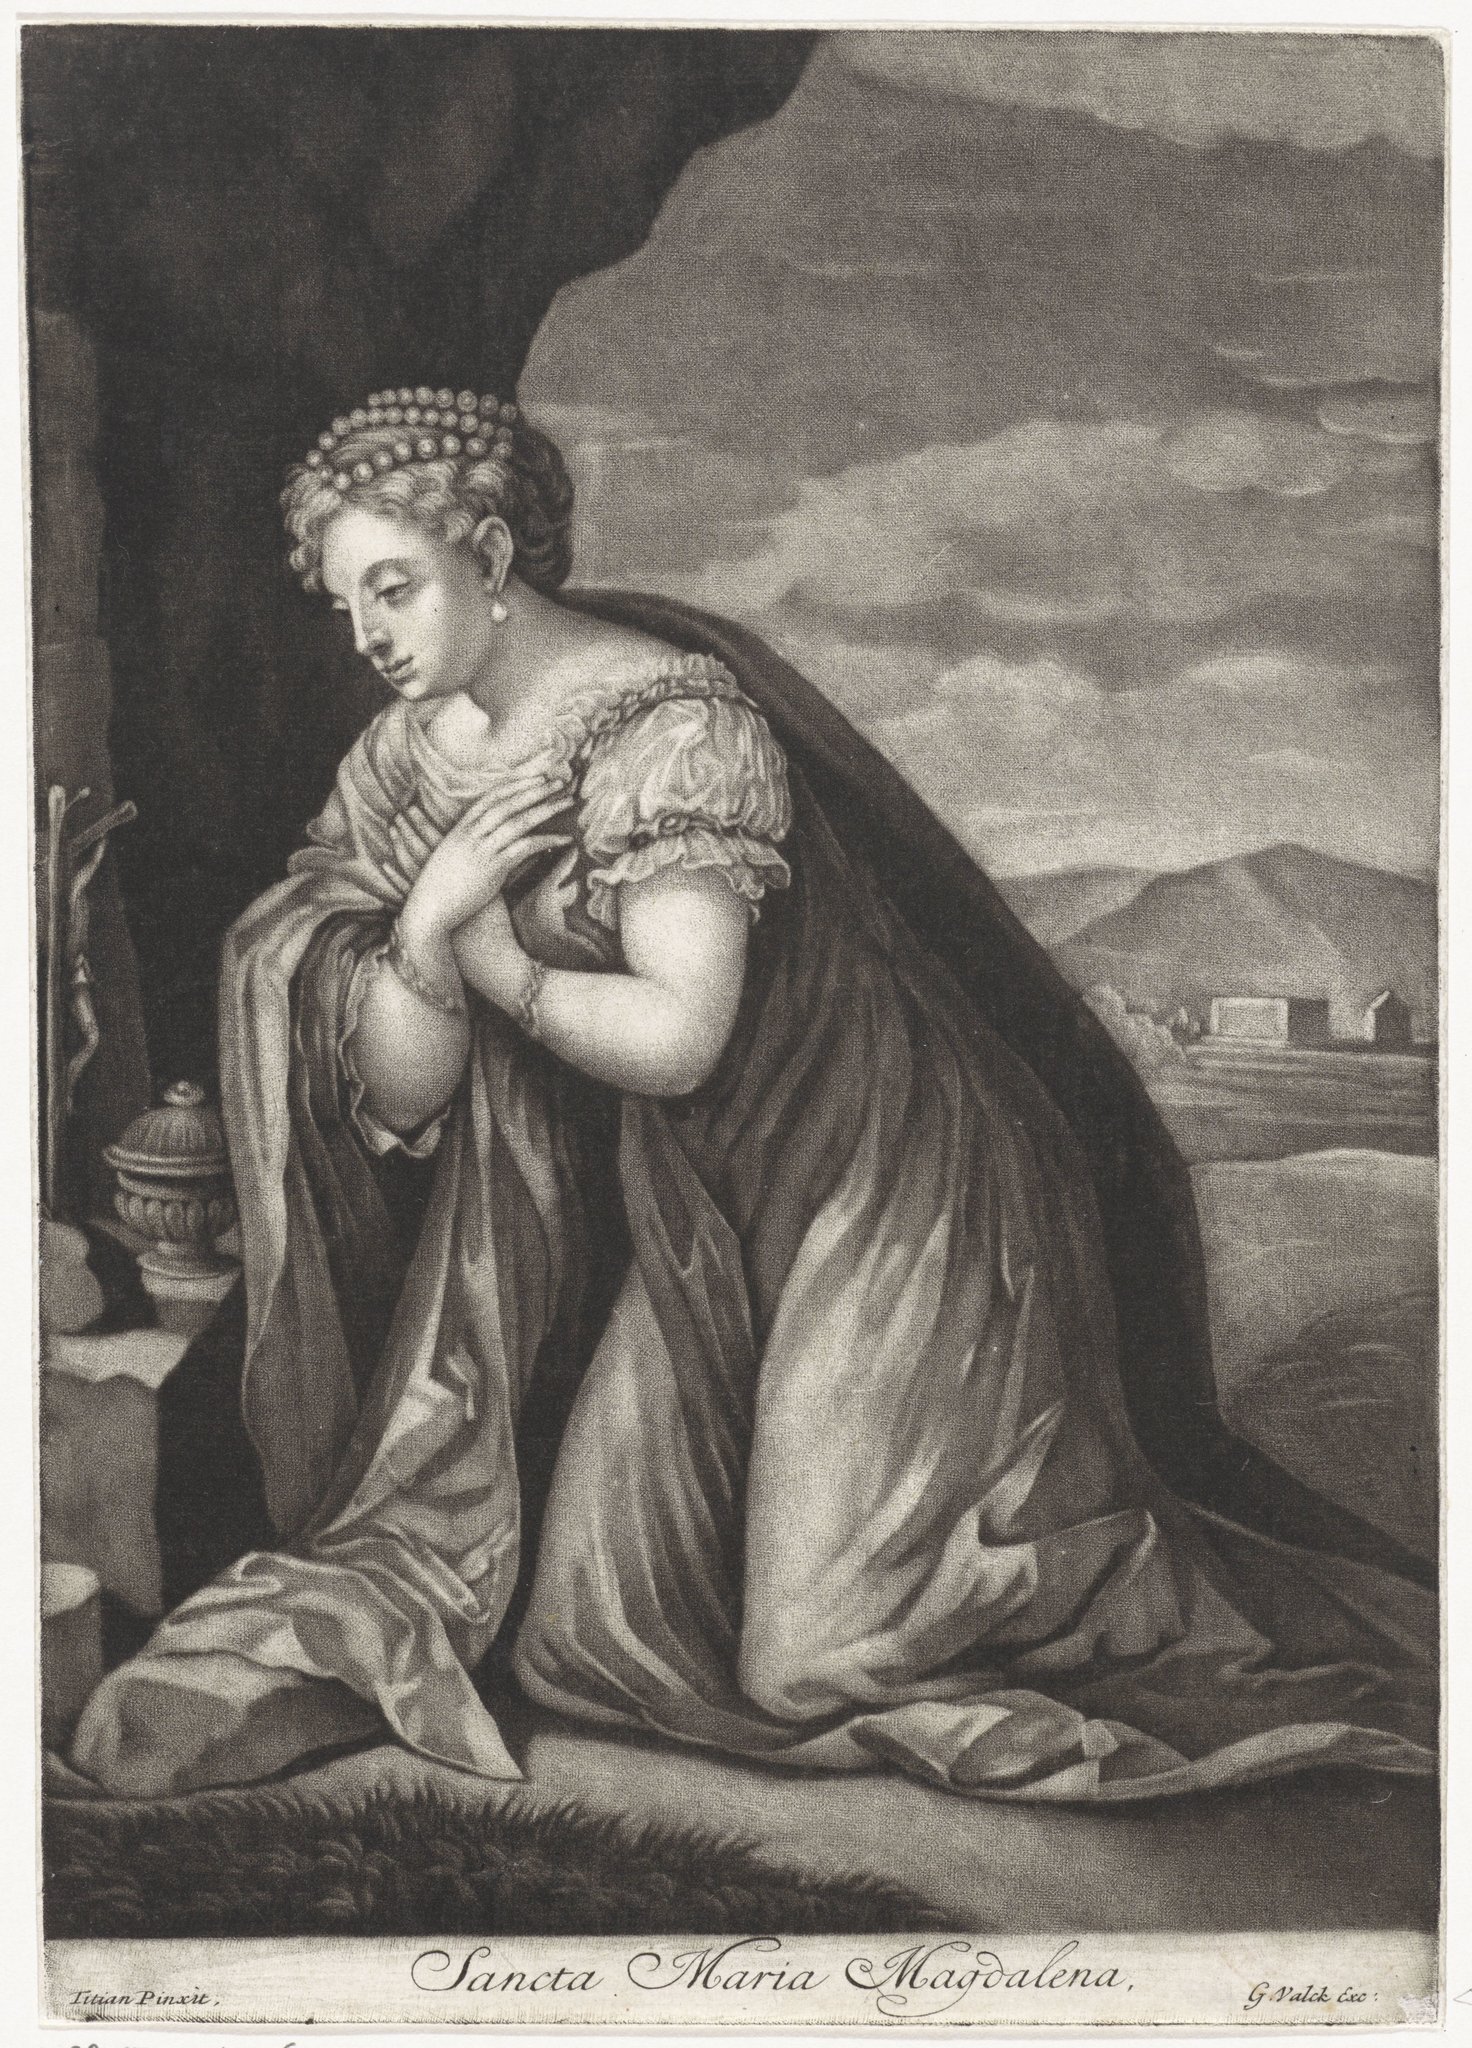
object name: print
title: Sancta Maria Magdalena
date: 1660-1726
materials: paper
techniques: mezzotint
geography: amsterdam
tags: the penitent harlot mary magdalene; possible attributes: book (or scroll), crown, crown of thorns, crucifix, jar of ointment, mirror, musical instrument, palm-branch, rosary, scourge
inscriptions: collector's mark: Lugt 240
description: De boetvaardige Maria Magdalena, biddend voor een crucifix bij een rots. Haar haren zijn versierd met een parelsnoer. Op de achtergrond een dorp.